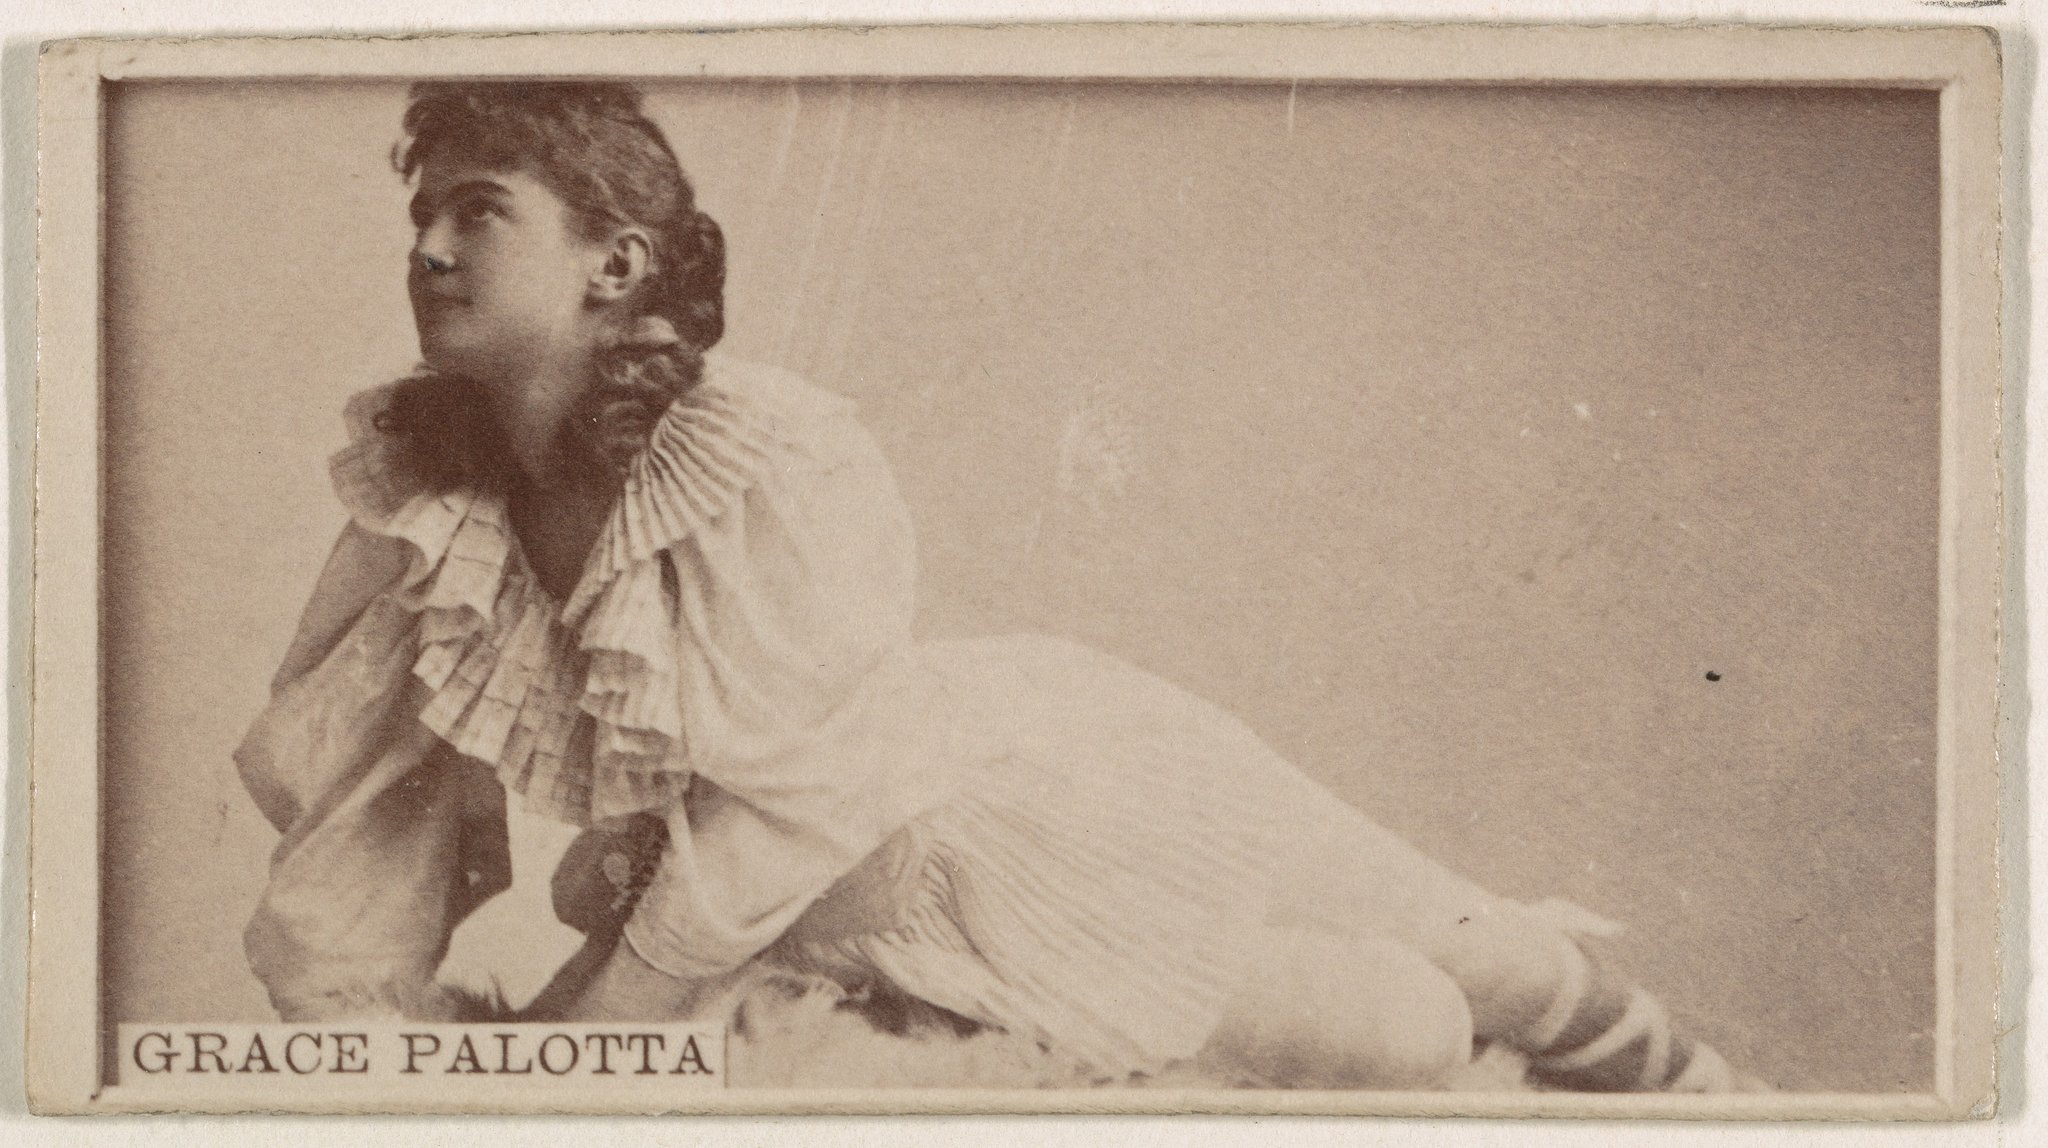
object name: photograph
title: Grace Palotta, from the Actresses series (N245) issued by Kinney Brothers to promote Sweet Caporal Cigarettes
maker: kinney brothers tobacco company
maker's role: publisher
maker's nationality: american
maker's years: 1869-2011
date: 1890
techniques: albumen silver print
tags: portraits,women,actresses